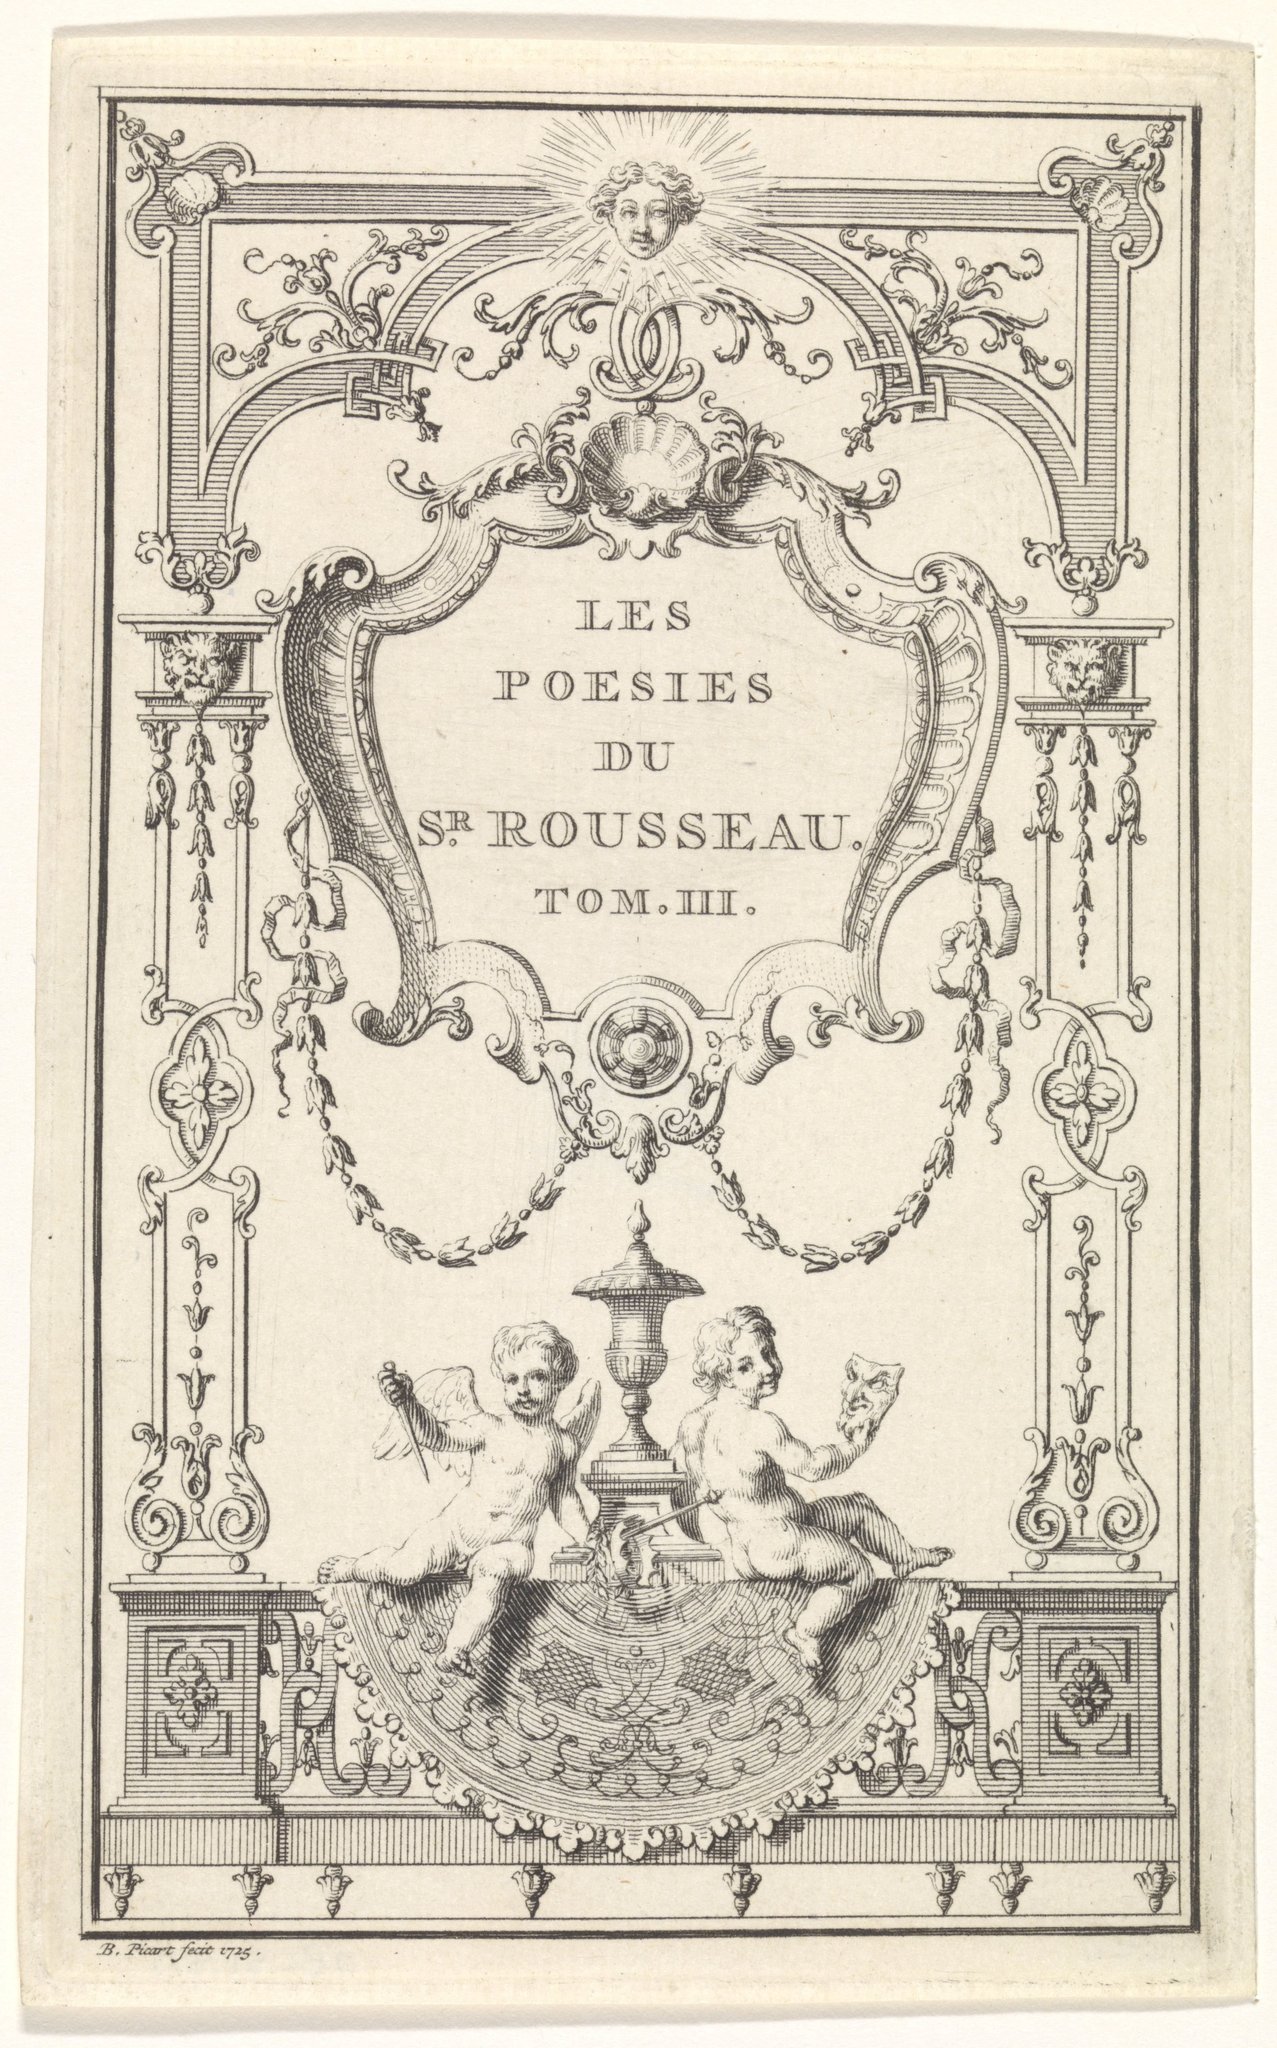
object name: titelblad, titelpagina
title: Titelpagina voor: J.-B. Rousseau, Oeuvres diverses, 1734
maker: bernard picart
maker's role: draughtsman, print maker, publisher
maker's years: 1673-1733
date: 1725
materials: paper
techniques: engraving, etching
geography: amsterdam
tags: symbolic representations, allegories and emblems ~ the theatre, ornaments ~ art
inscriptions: collector's mark: Lugt 240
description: Ornamentele omlijsting met in het midden een cartouche waarin de titel in het Frans. Onderaan twee putti met in de handen attributen die verwijzen naar het theater.